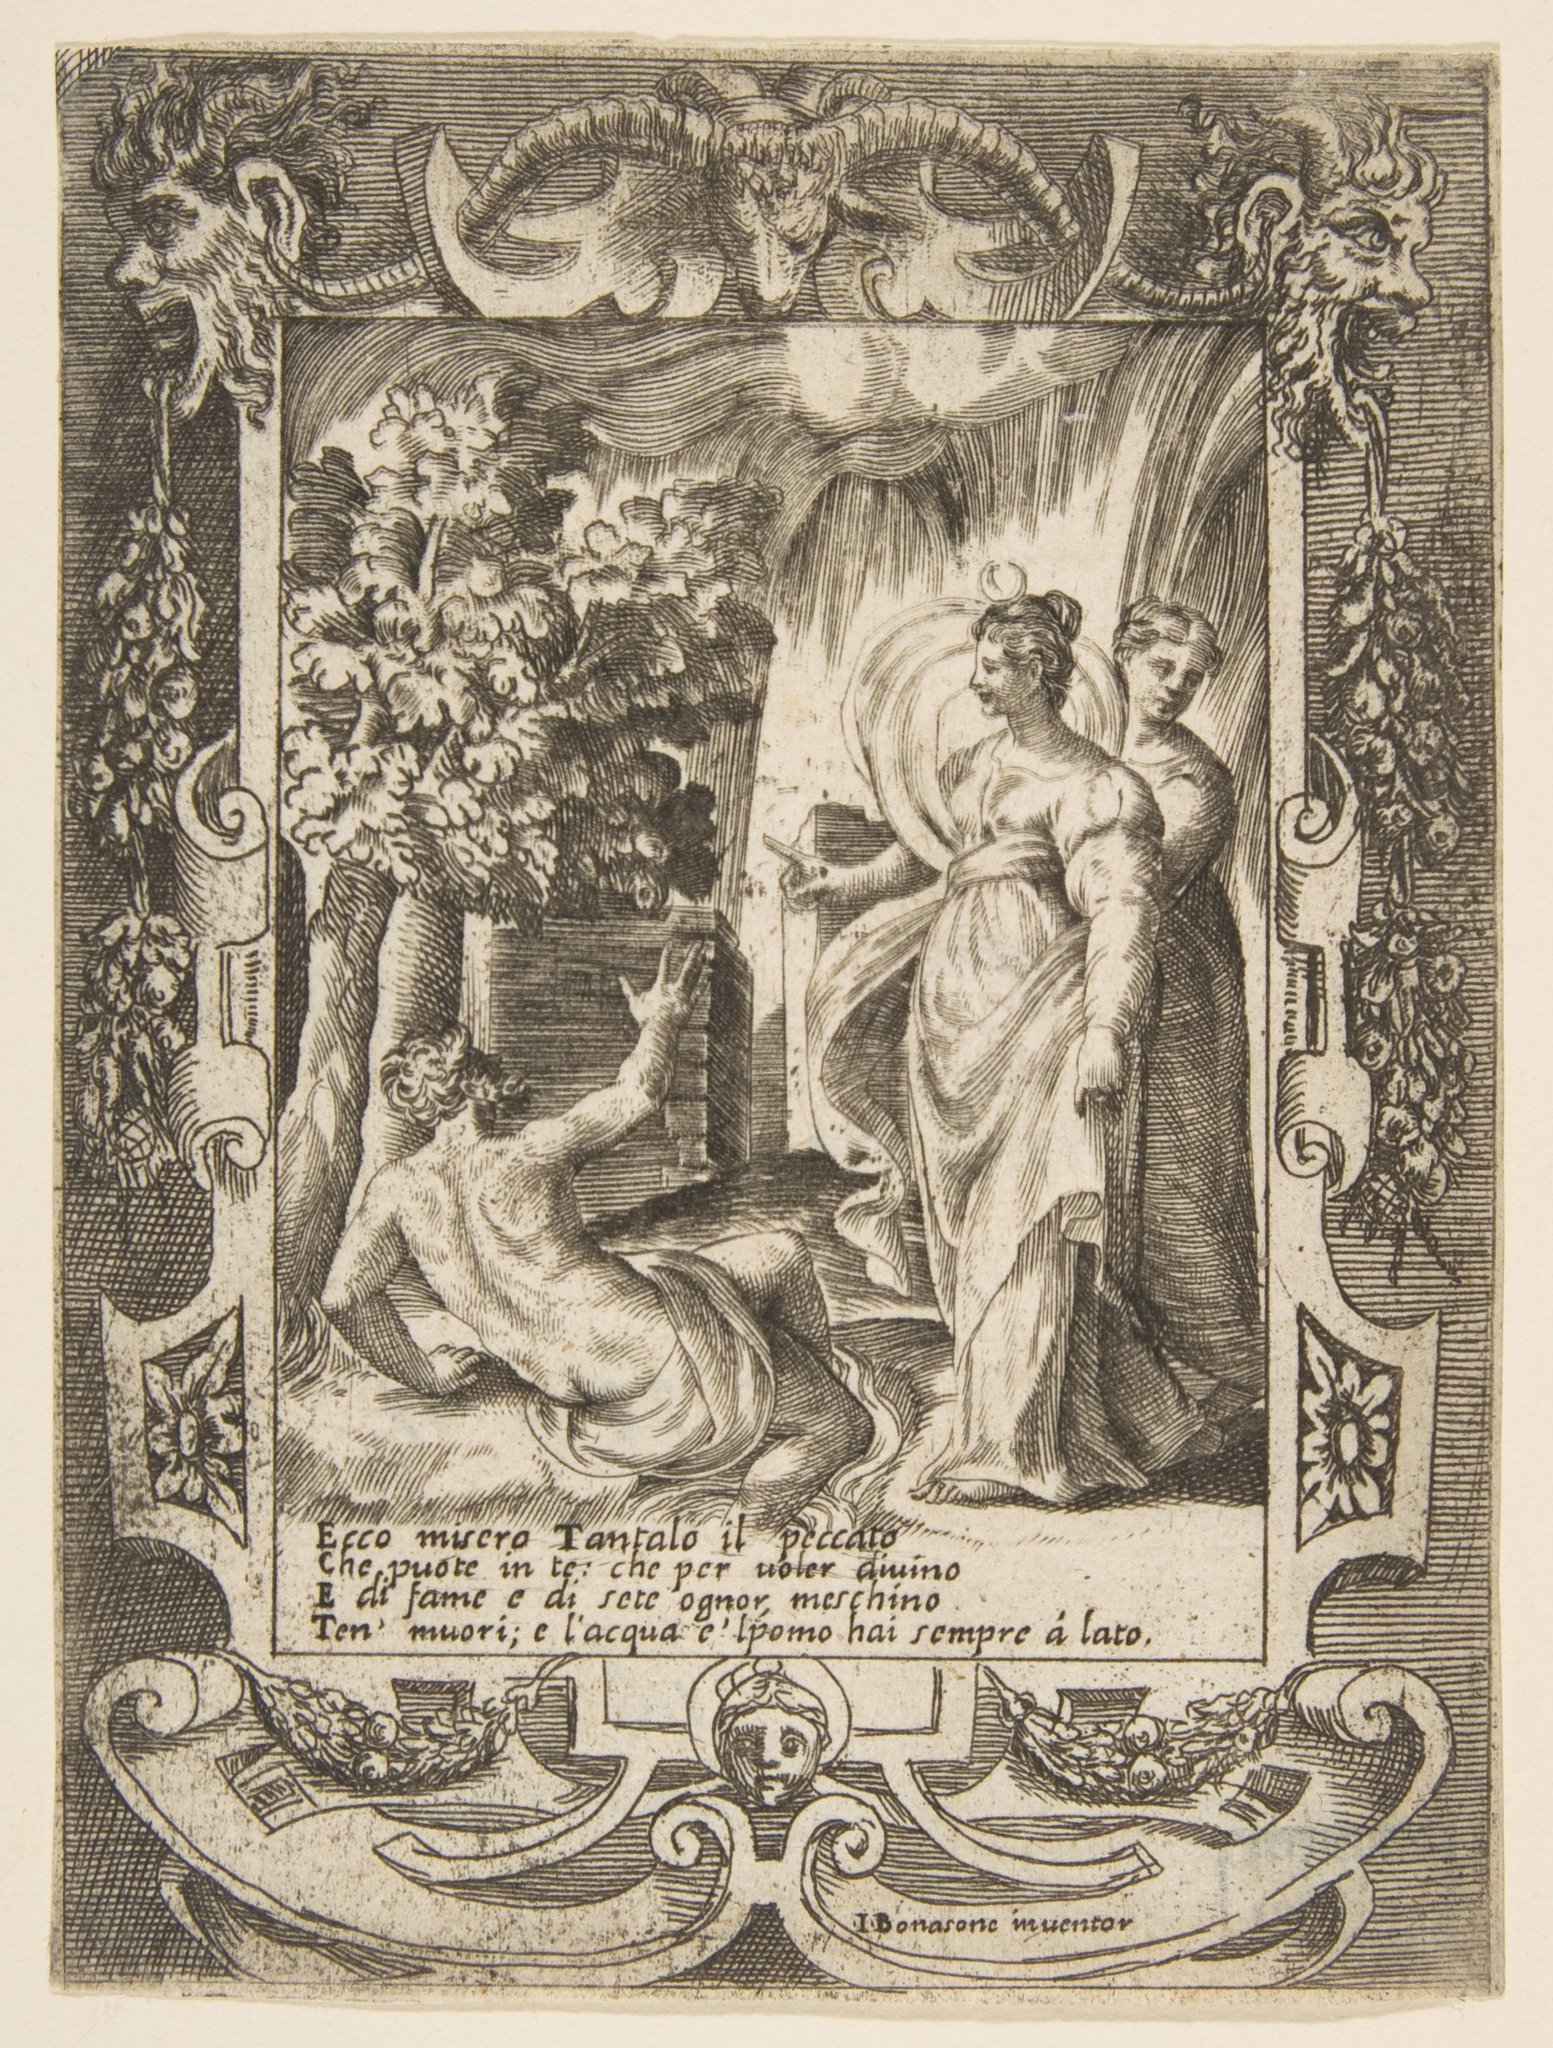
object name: print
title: Tantalus at left speaking to Diana at right, set within an elaborate frame, from "Loves, Rages and Jealousies of Juno"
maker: giulio bonasone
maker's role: artist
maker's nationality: italian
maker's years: 1510-1576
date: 1531-1576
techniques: engraving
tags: men,women,diana,trees